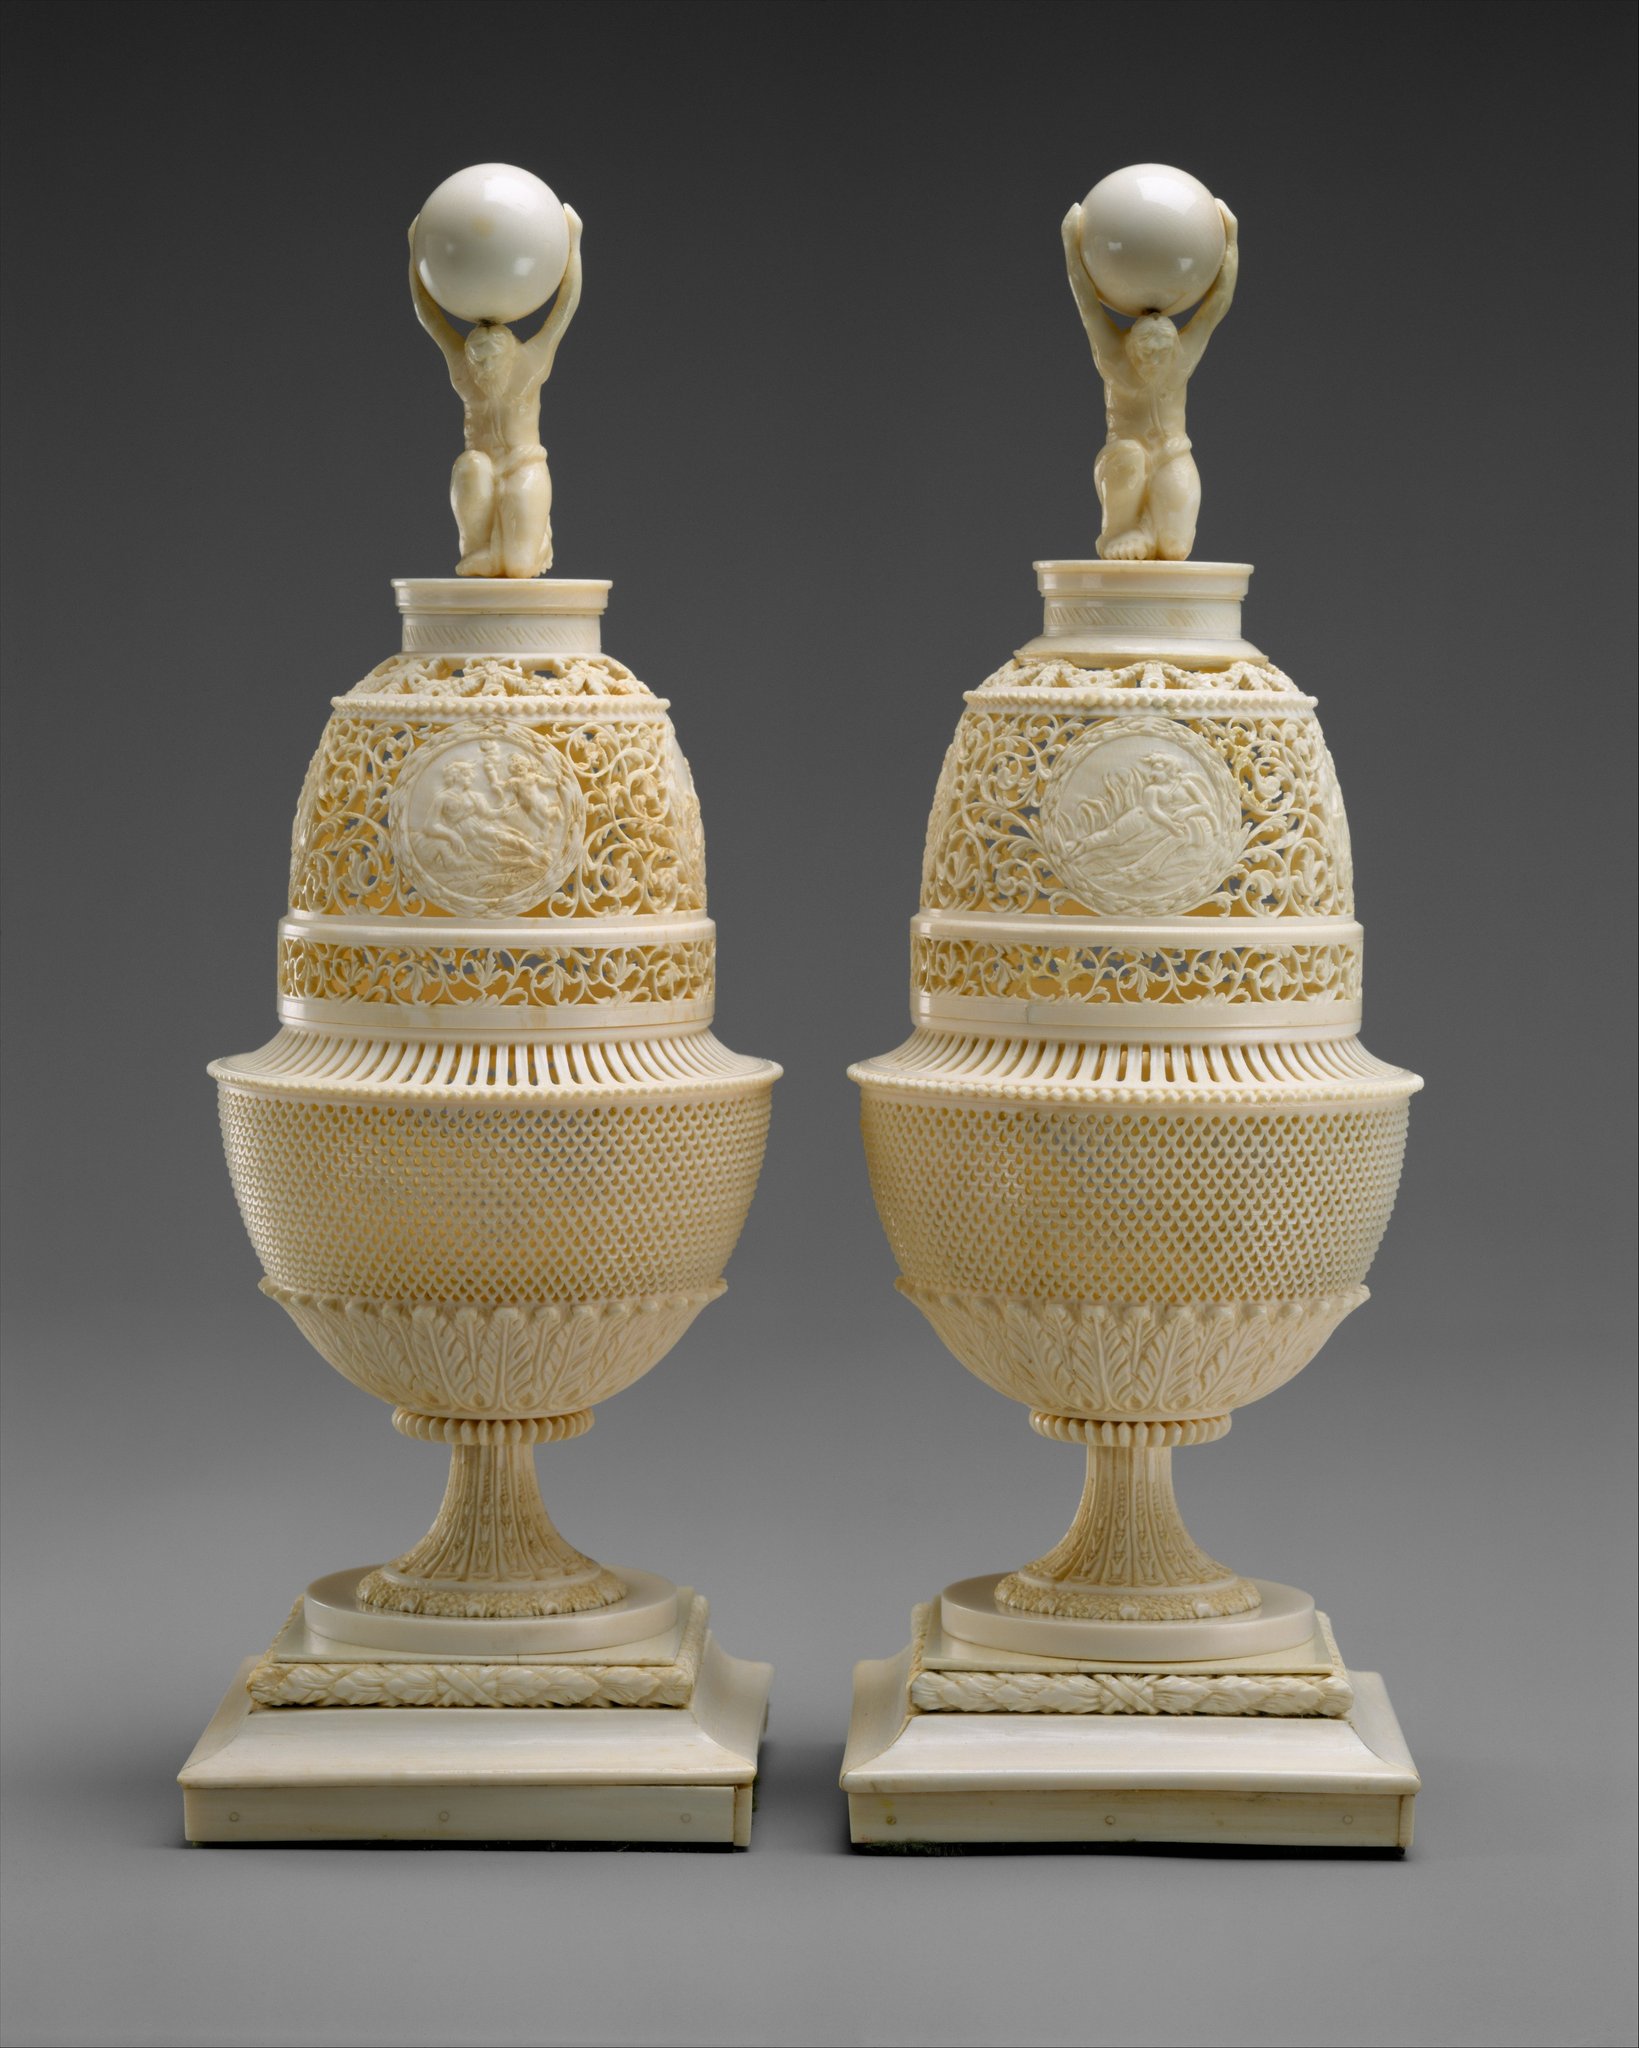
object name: vase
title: Pair of vases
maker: nikolai stepanovich vereshchagin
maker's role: artist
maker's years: 1795-1813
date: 1795-1800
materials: ivory